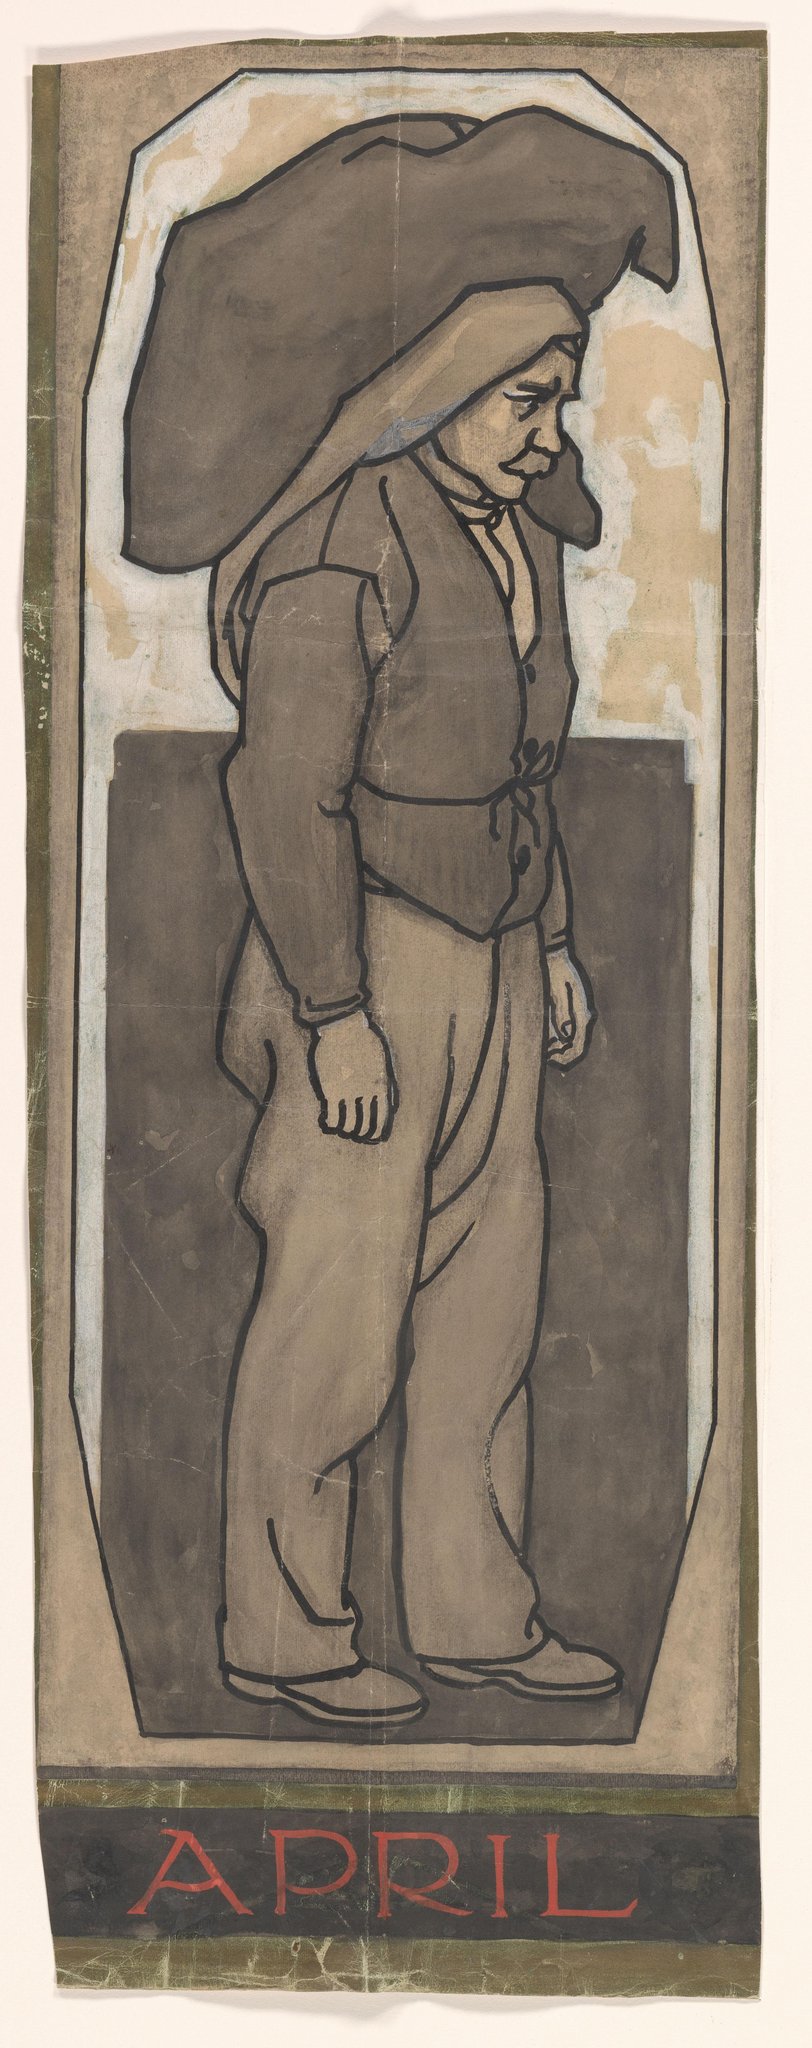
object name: drawing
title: Ontwerptekening voor midden van tegeltableau ter ere van het 25-jarig bestaan van de Steenkolen-Handelsvereeniging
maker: carel adolph lion cachet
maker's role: draughtsman, print maker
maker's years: 1864-1945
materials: chalk, paint, paper, pencil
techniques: brush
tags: steamship, motorship (+ taking in fuel; feeding the animals), anthracite, hard coal, names of organizations, companies, trade unions, etc., porter, bearer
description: Het tegeltableau is waarschijnlijk bewaard in het hoofdkantoor van SHV Holdings aan de Rijnkade te Utrecht.